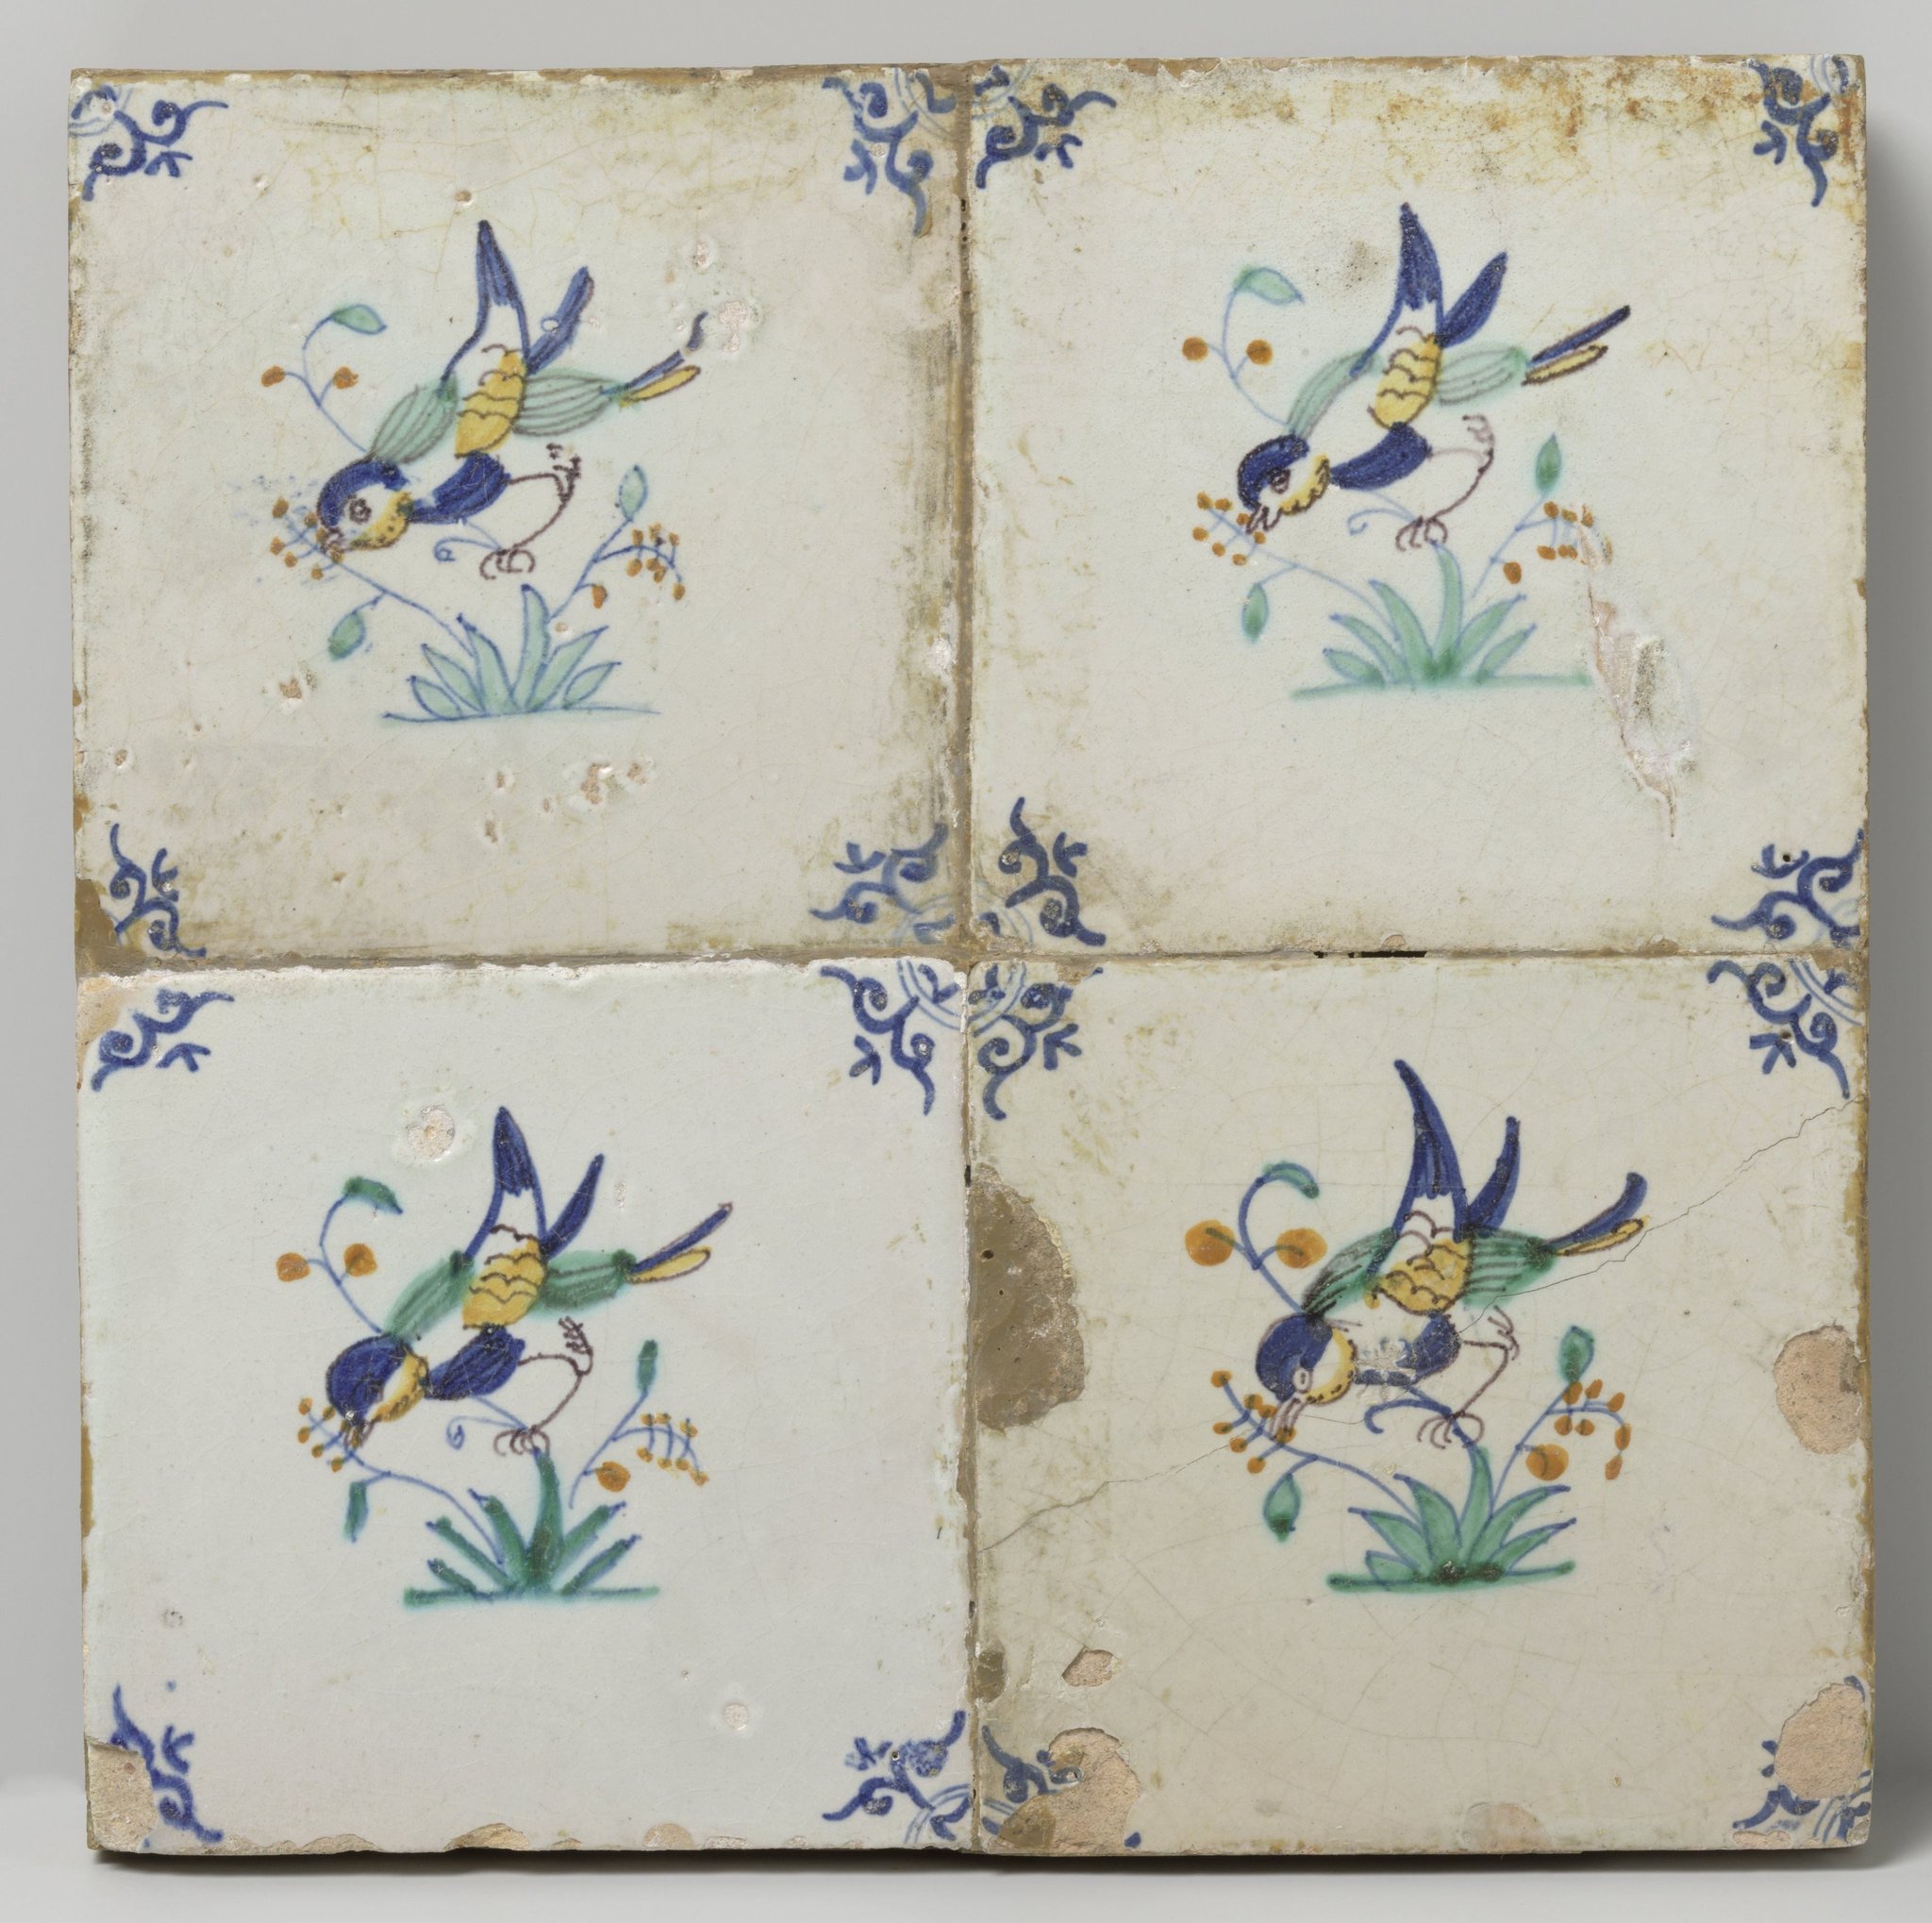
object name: tile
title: Veld van vier tegels met vogels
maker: Anonymous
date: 1640-1660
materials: earthenware, glaze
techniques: maiolica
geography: netherlands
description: Veld van vier tegels (2 x 2) elk met een veelkleurige (blauw, groen, geel, oranje en paars) vogel op een tak. In de hoeken, een ossenkop.